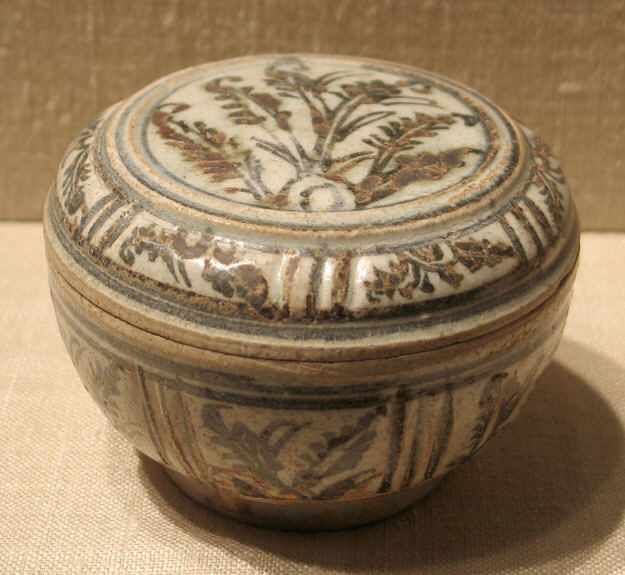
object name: covered box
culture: thai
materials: earthenware, glaze, iron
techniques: underglaze